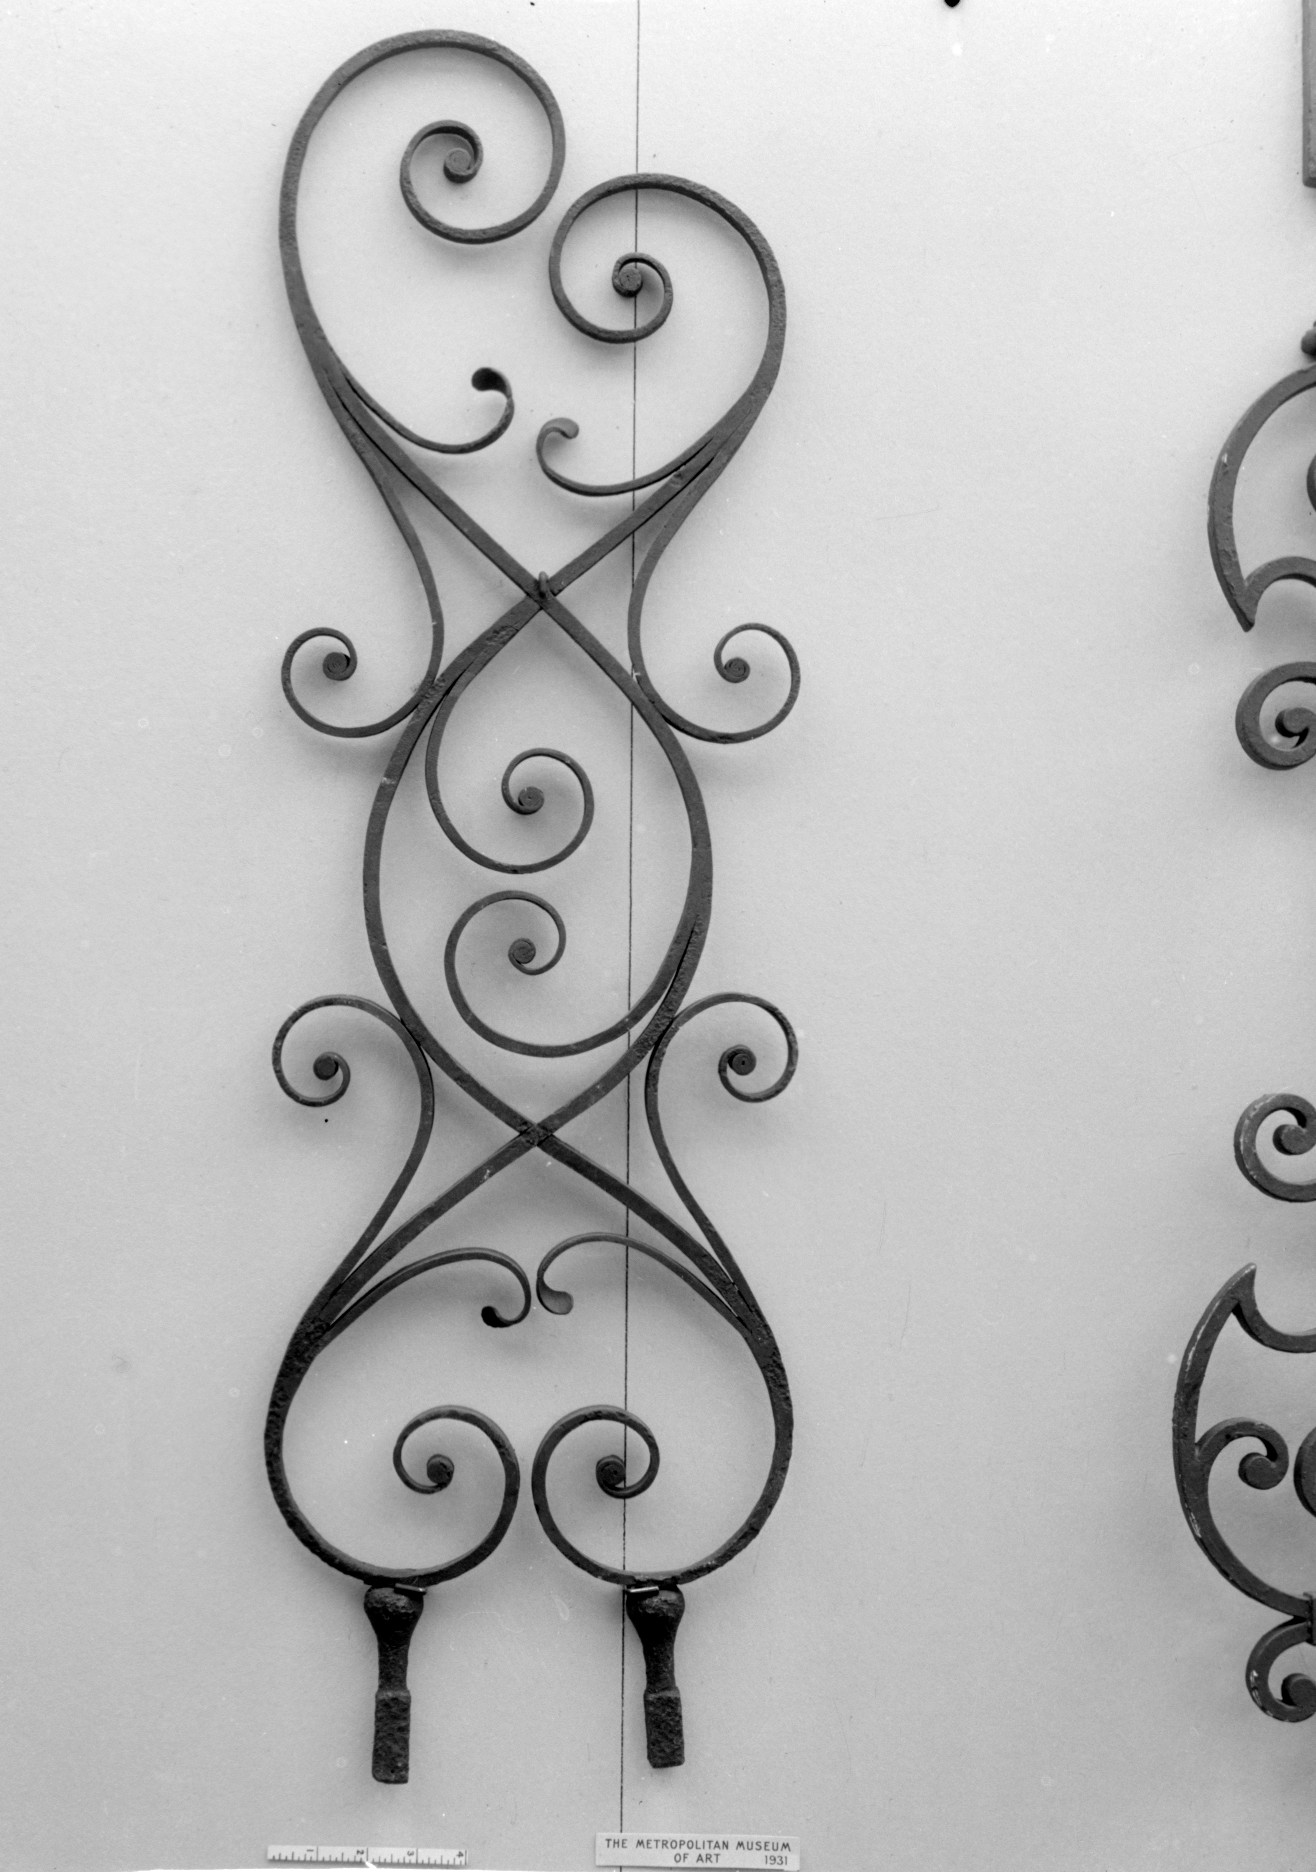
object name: baluster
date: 1701-1800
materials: iron